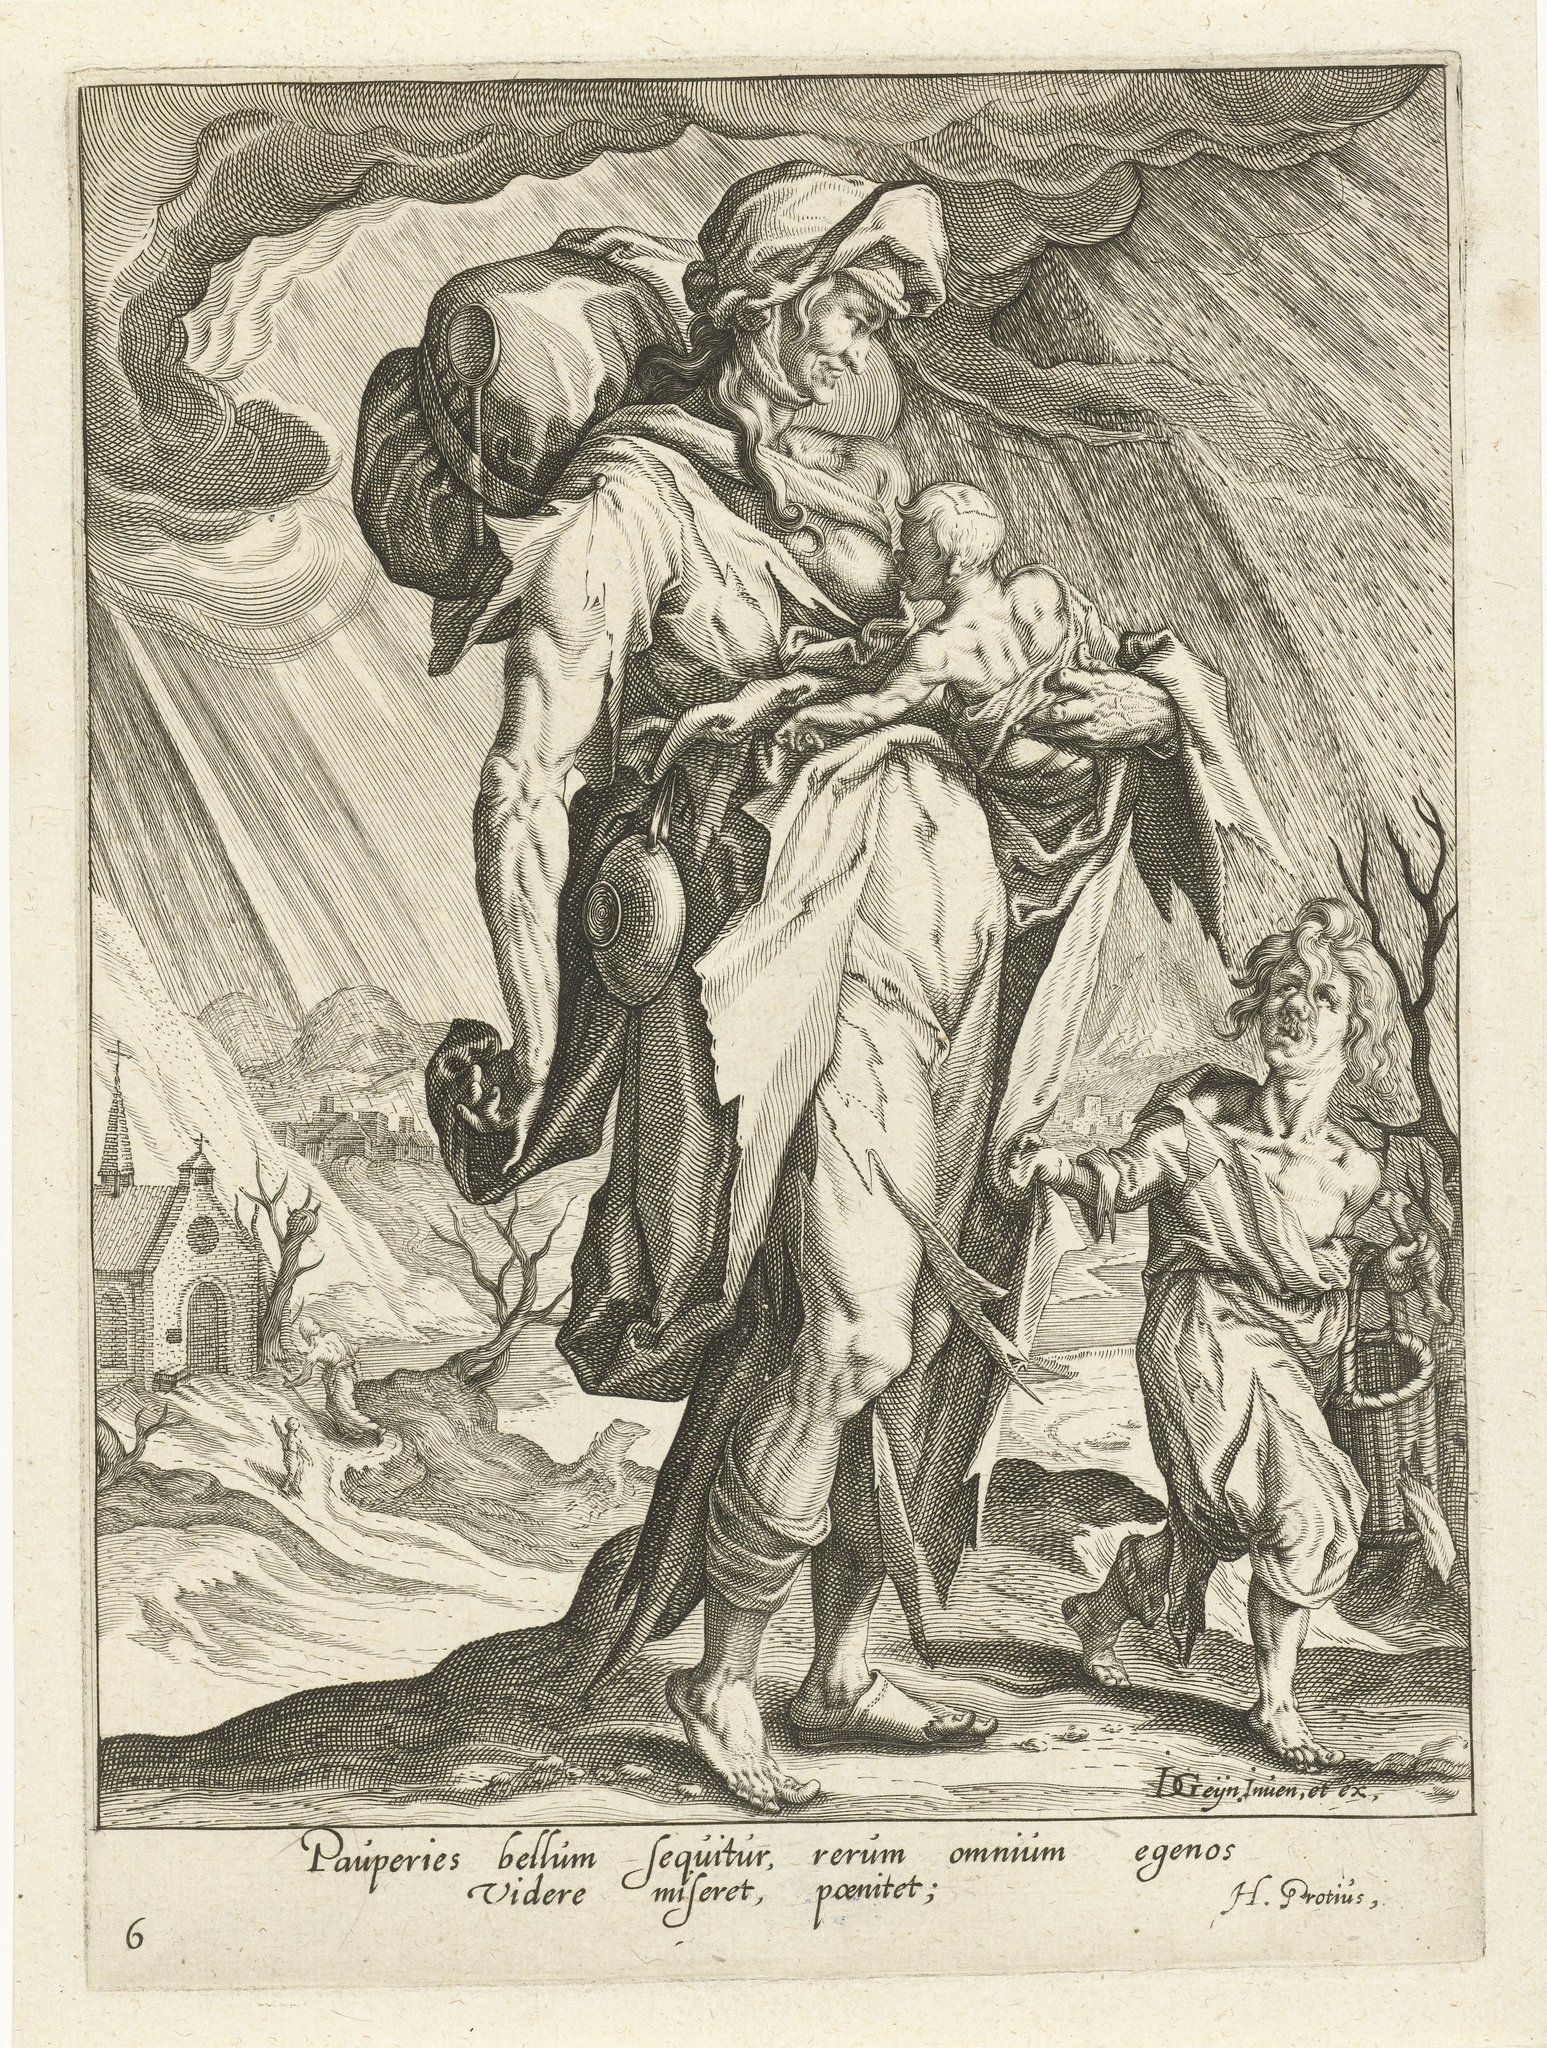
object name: print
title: De lotgevallen van het leven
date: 1596-1597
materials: paper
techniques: engraving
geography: leiden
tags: nursing, suckling, poverty; 'povertà', 'povertà del doni', 'povertà in uno ch'habbia bell'ingegno' (ripa), vicissitudes of life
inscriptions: signature: ‘H. Grotius’, number: ‘6’, collector's mark: Lugt 2228, signature and address: ‘IDGheyn Inven. et ex.’, caption: ‘Pauperies bellum seguitur, rerum omnium egenos / Videre miseret, poenitet’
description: Armoedig geklede vrouw met bundel op haar rug, een zogend kind aan de borst, staand in de regen. Naast haar een kind met een mand. Op de achtergrond een kaal landschap met links een kerkje. Nr. 6 uit serie deugden en ondeugden die de lotgevallen van het leven bepalen.